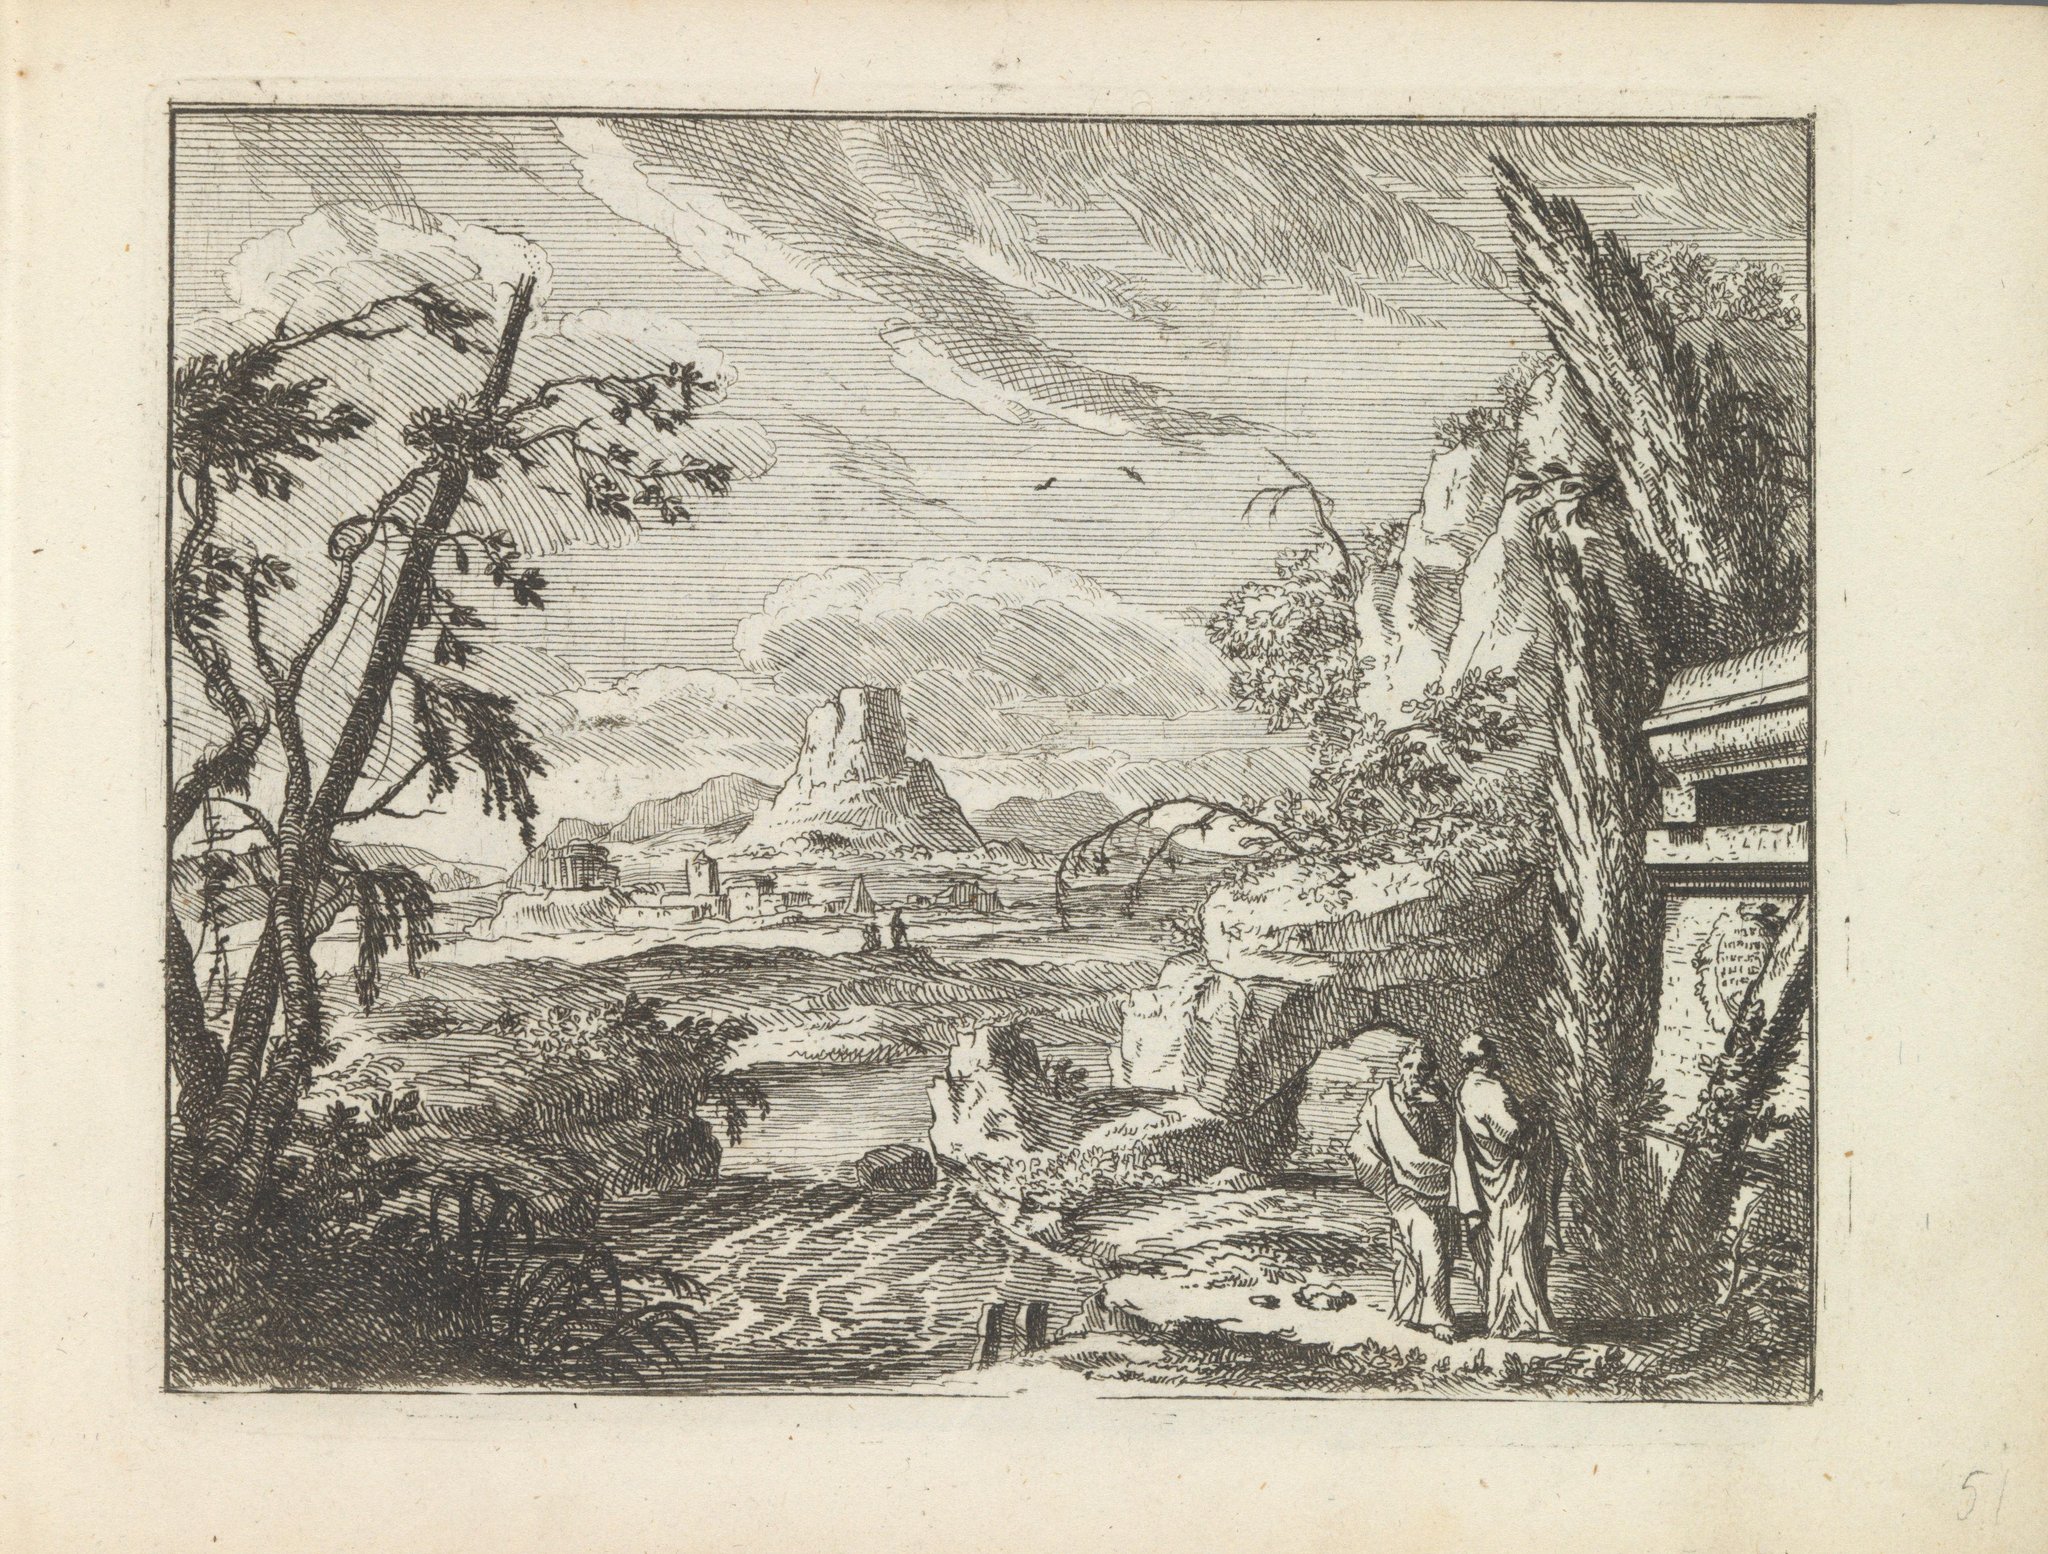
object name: print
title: Spiegel der natuur en school der teekenkunde (...)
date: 1701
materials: paper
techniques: etching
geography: amsterdam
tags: landscape with ruins, grave, tomb, pastorals, arcadian scenes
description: Gezicht op een landschap met bergen en ruïneuze gebouwen. Op de voorgrond staan twee mannen bij een gebouw, mogelijk een tombe. De prent maakt deel uit van een album.